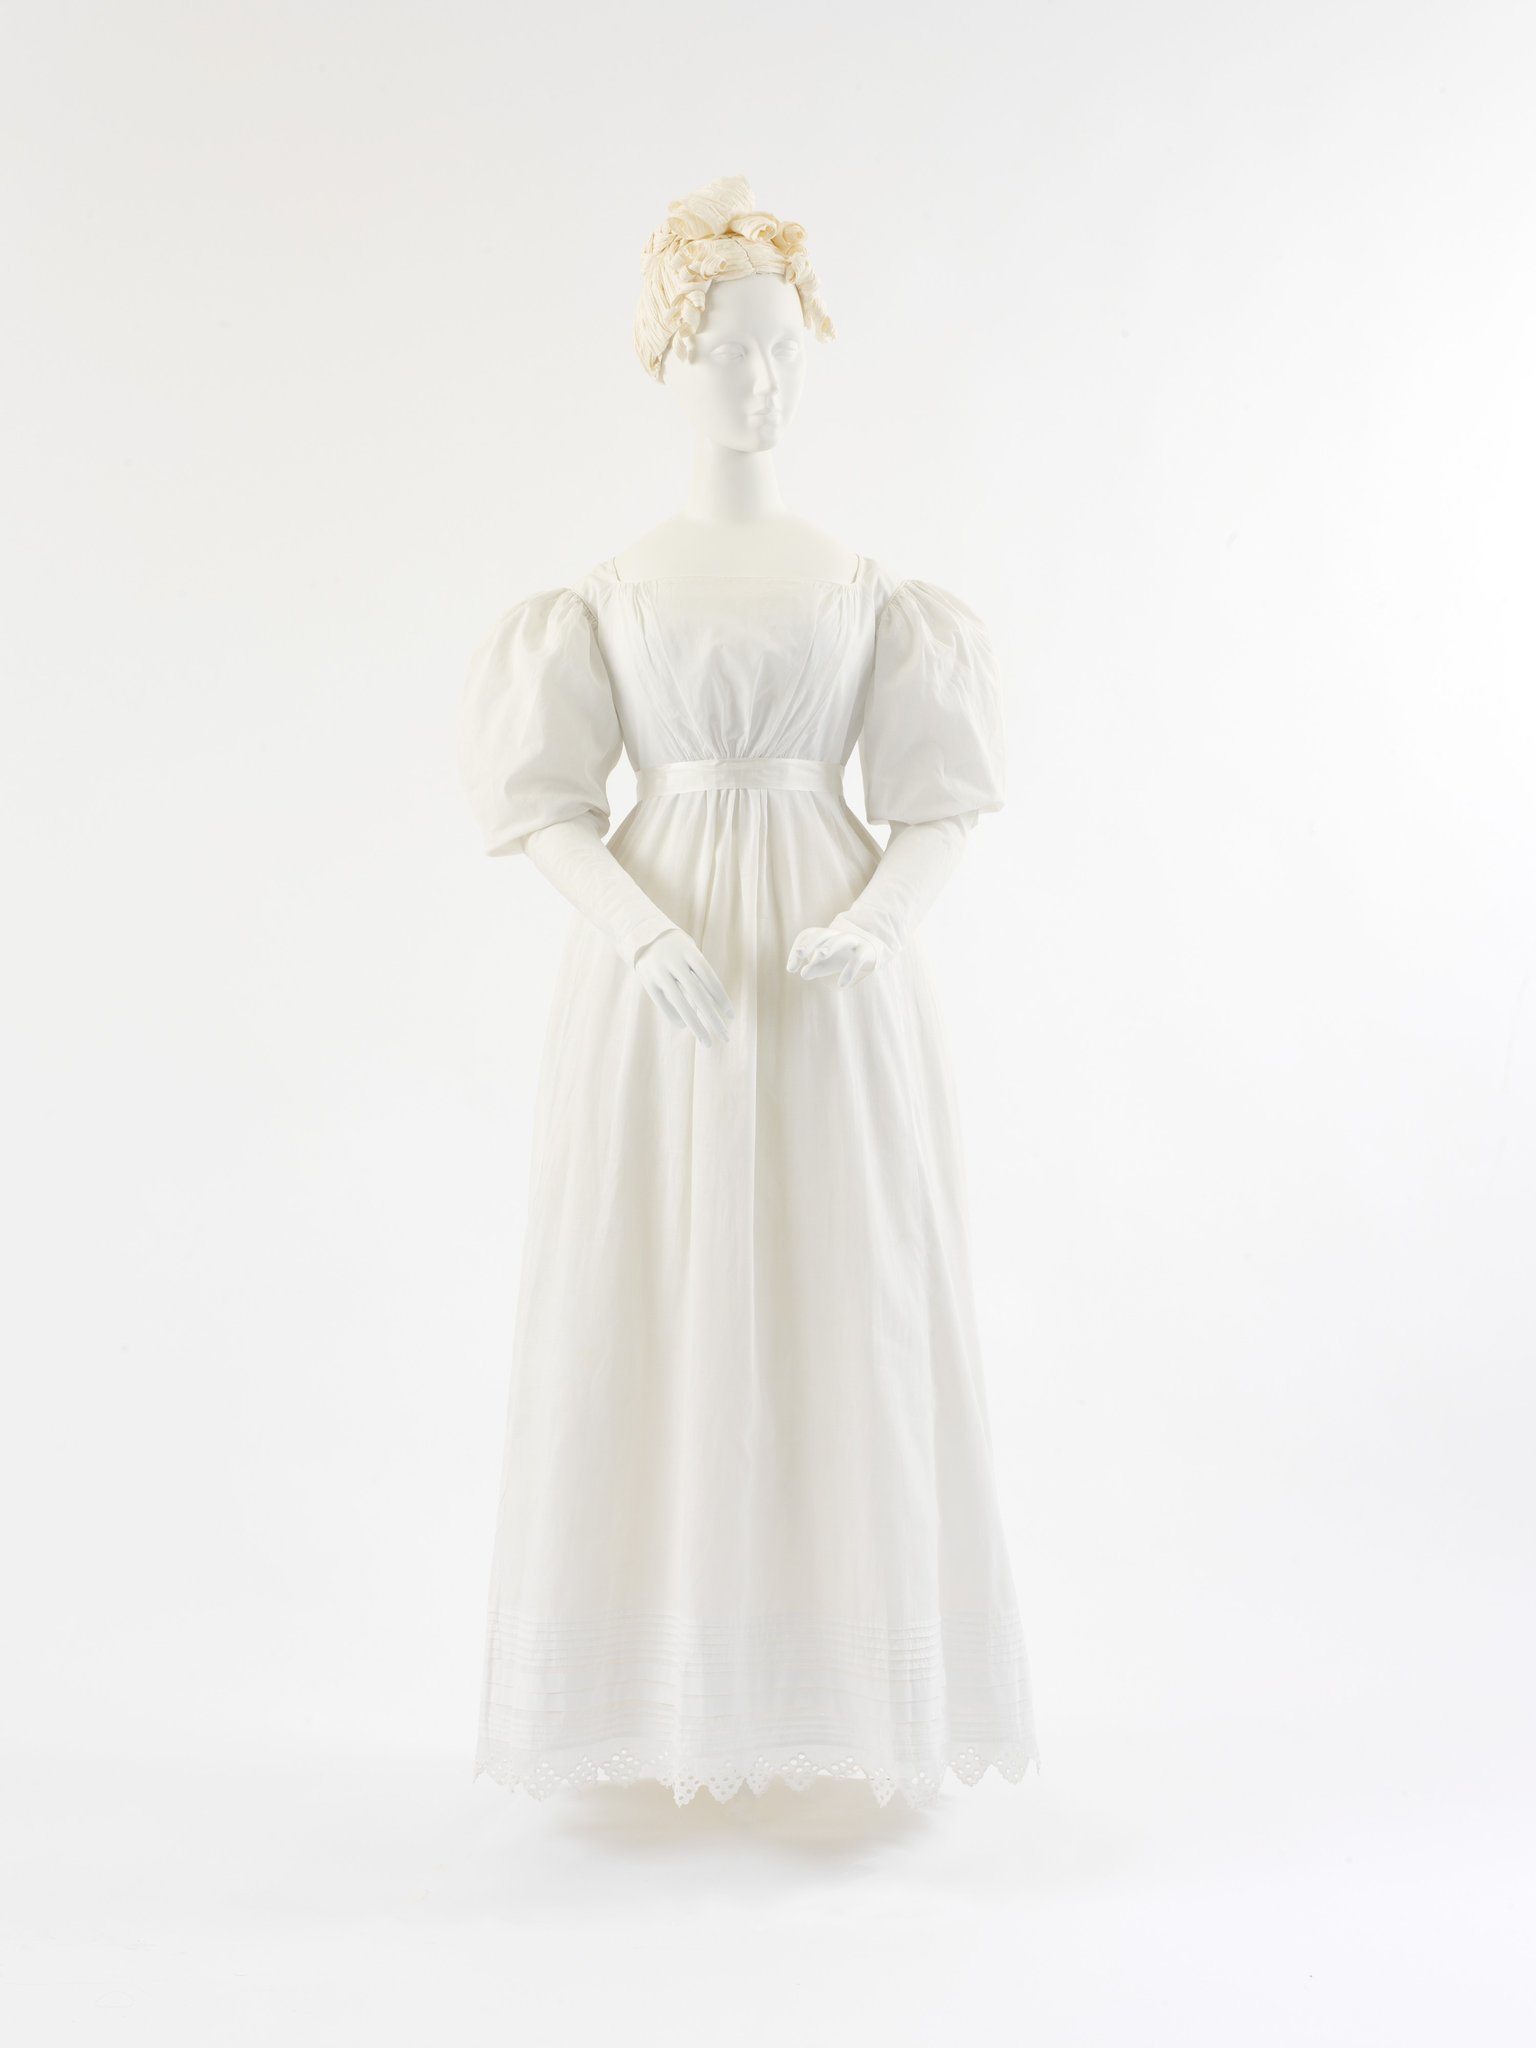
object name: underdress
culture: american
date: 1822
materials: cotton